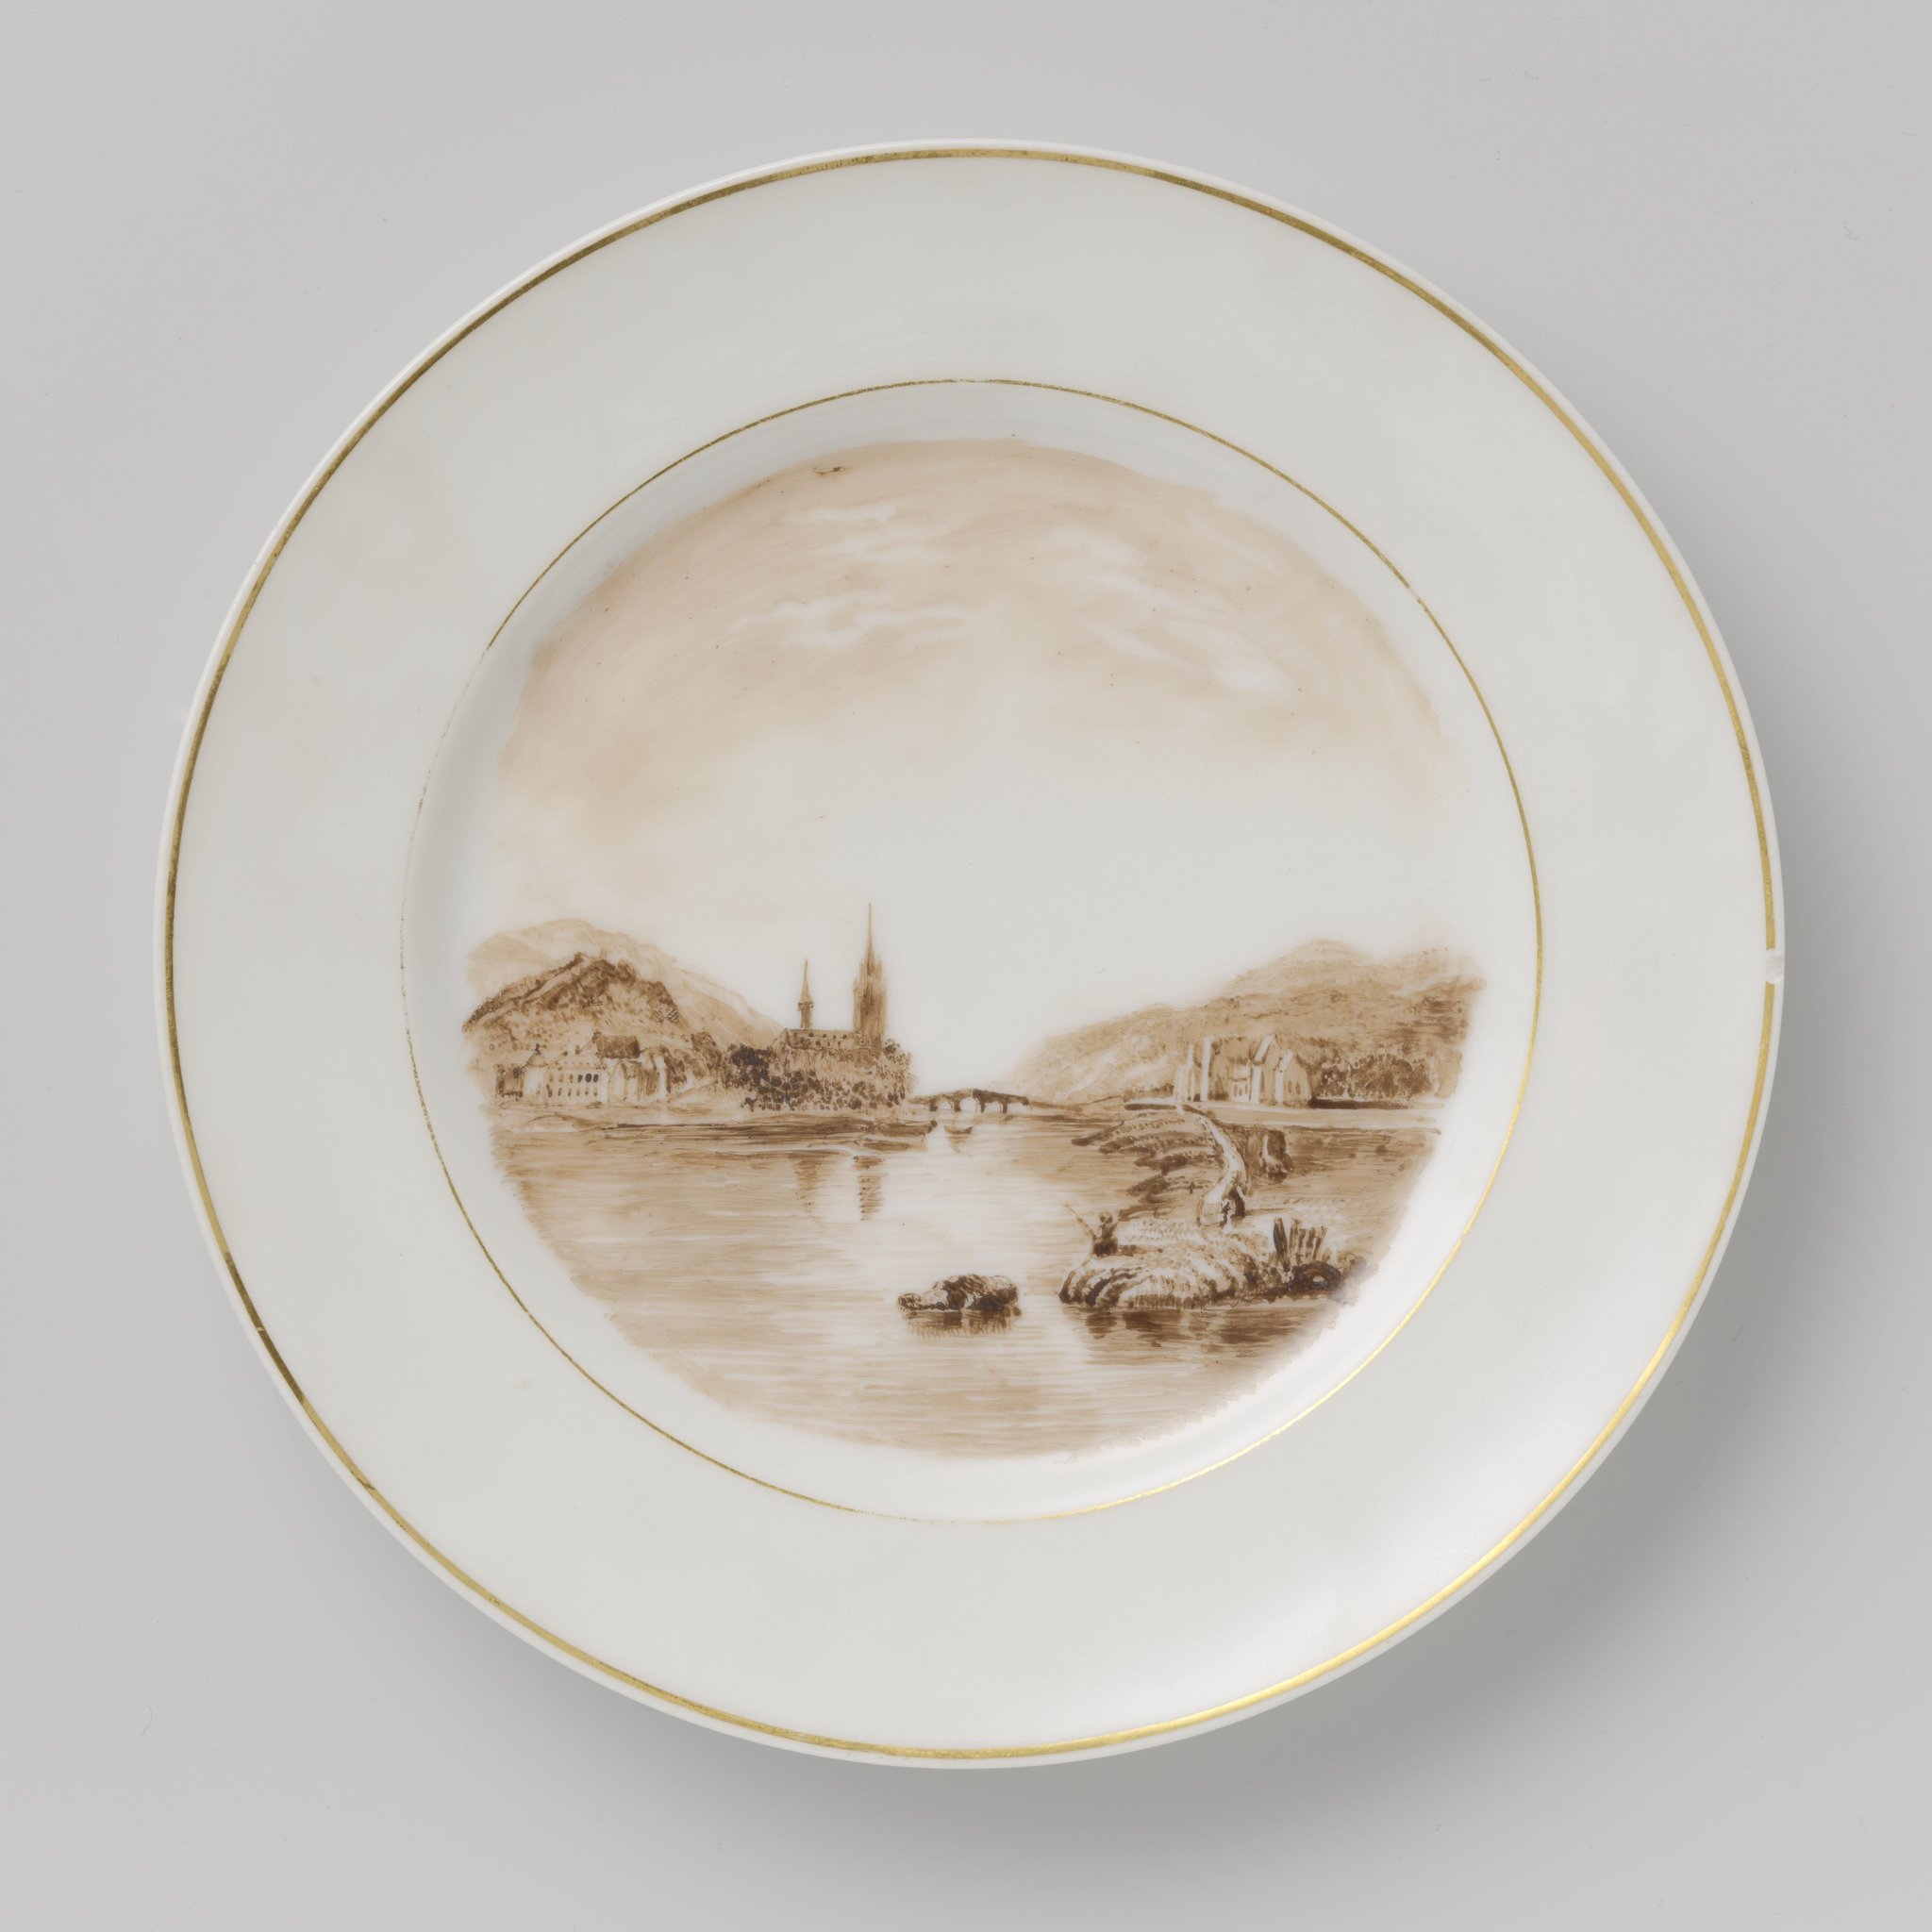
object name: service set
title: Plate with a landscape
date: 1850-1860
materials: glaze, gold, paint, porcelain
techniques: firing, forming, gilding, turning, vitrification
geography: europe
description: Bord van porselein, beschilderd op het glazuur in sepia en goud. Op het plat een landschap met een visser op een pier en in de achtergrond twee dorpen verbonden door een brug. Gouden rand. Een proen op de onderzijde.